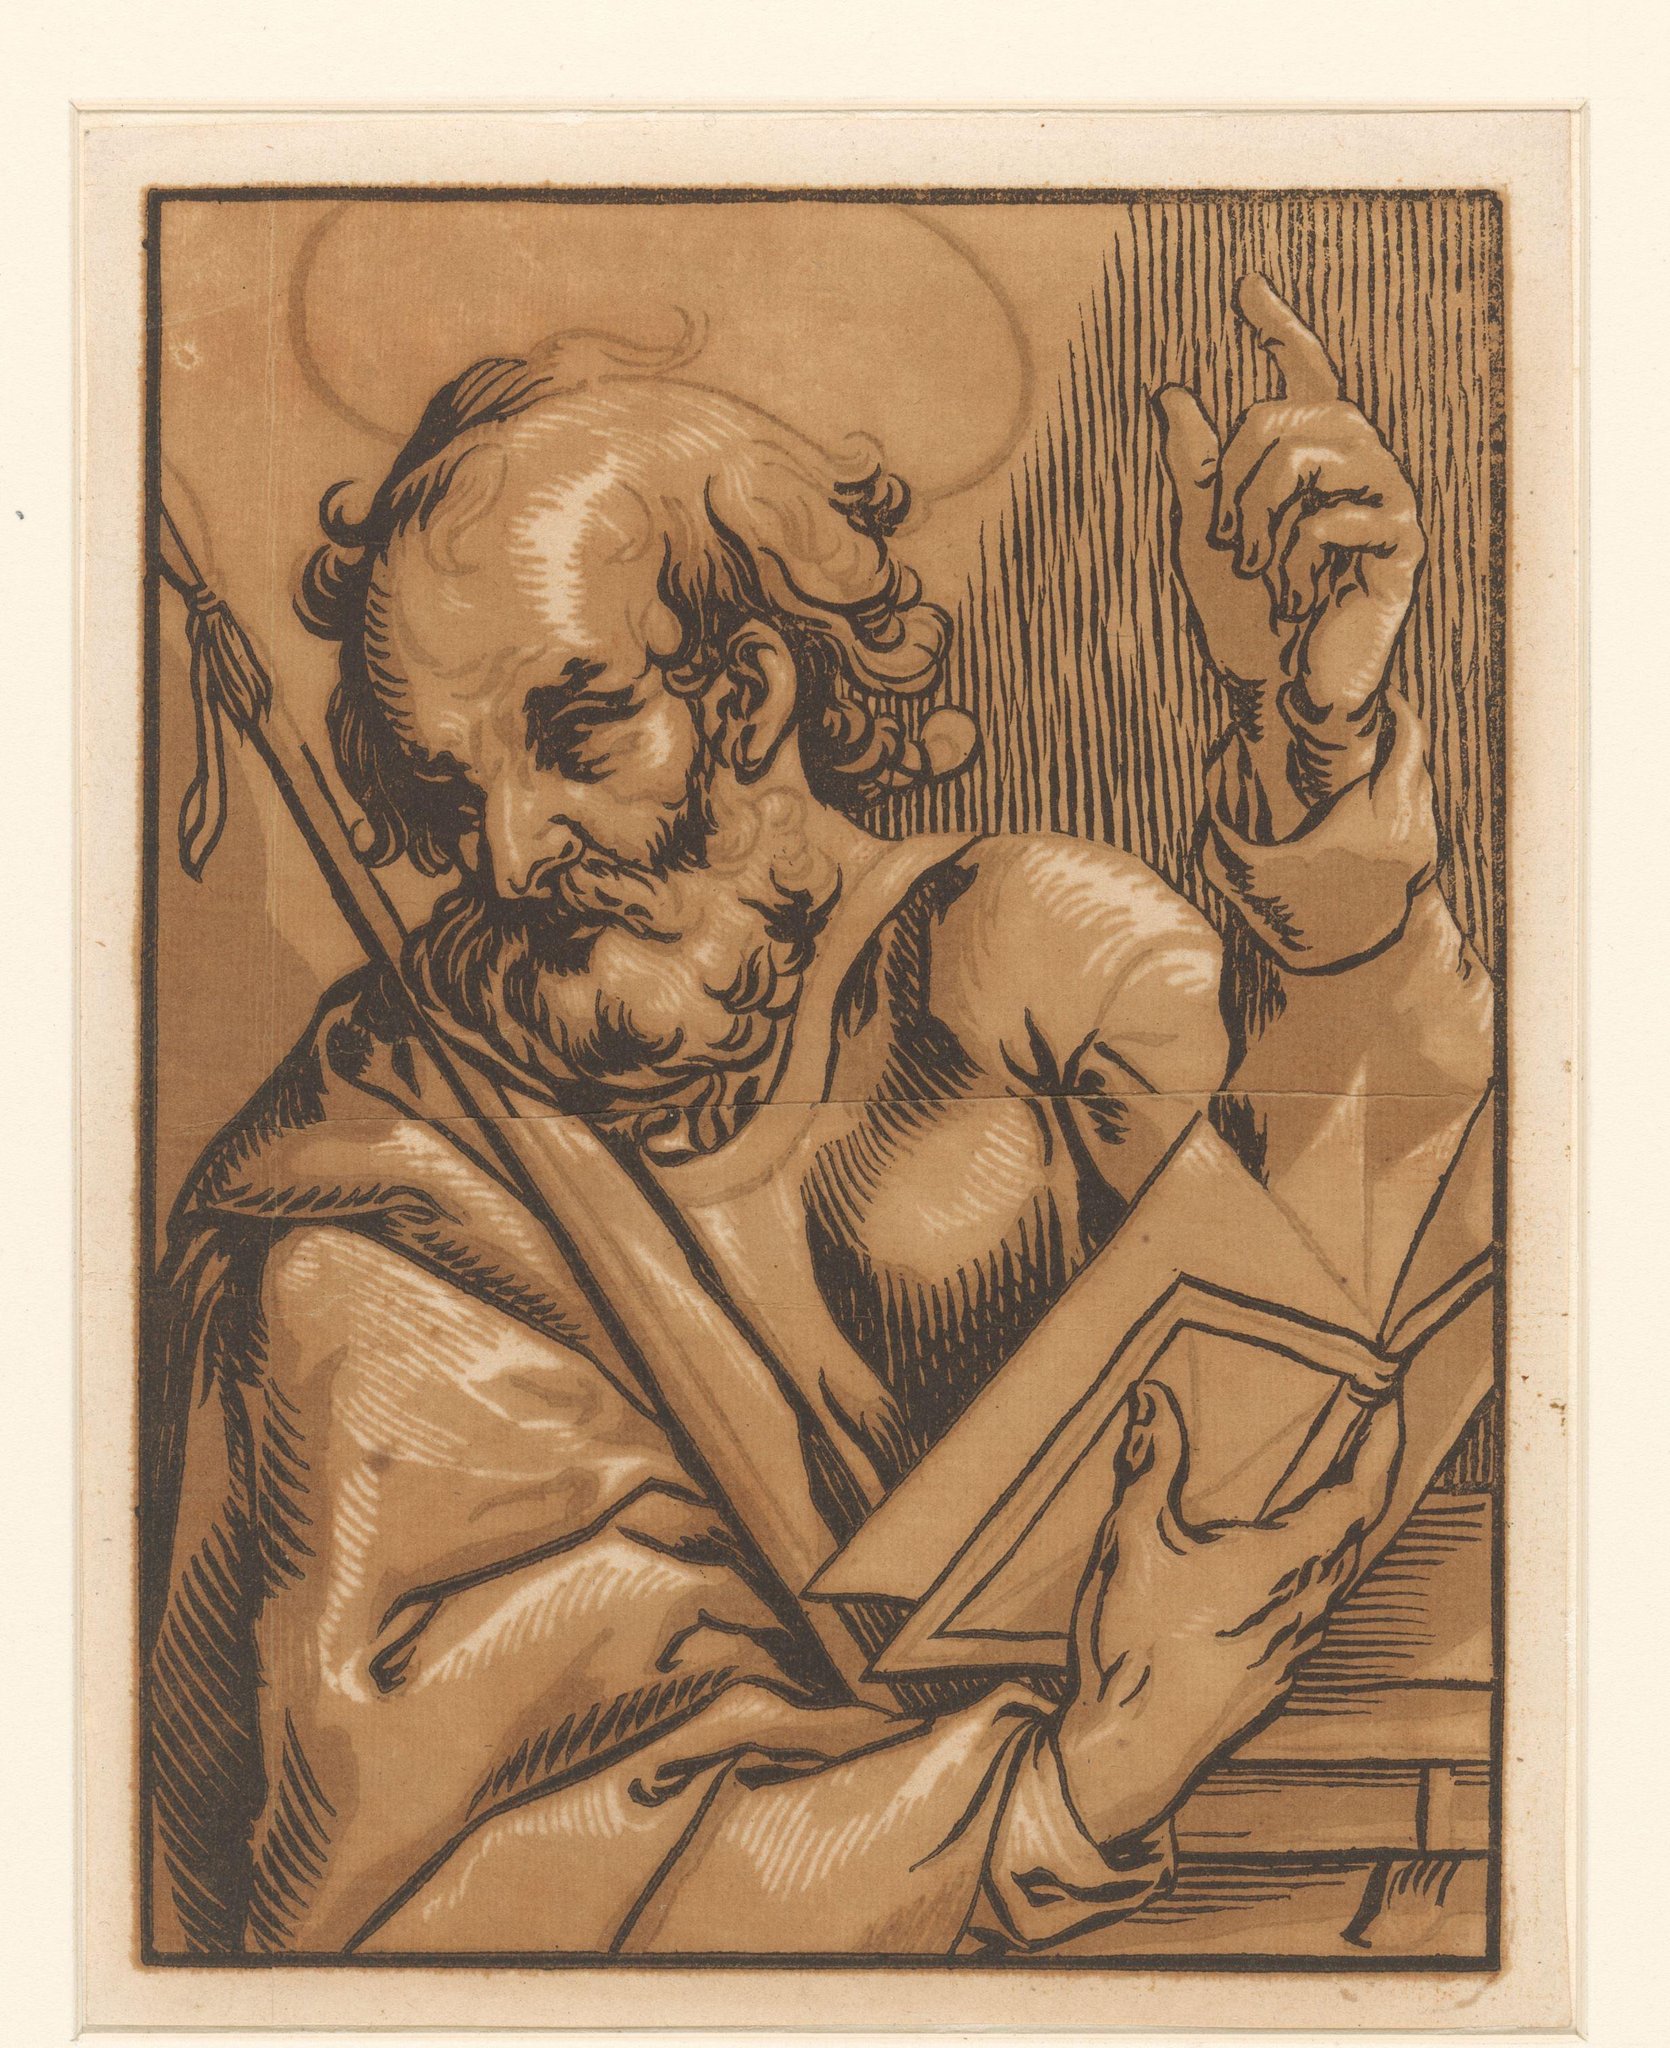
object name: print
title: Christus en de twaalf apostelen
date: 1600-1669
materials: paper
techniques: woodcut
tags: the apostle philip; possible attributes: book, cross, dish with snake, lance, scroll, stone, sword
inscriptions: collector's mark: Lugt 240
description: Onderdeel van een serie van twaalf prenten met afzonderlijk Christus en de apostelen.